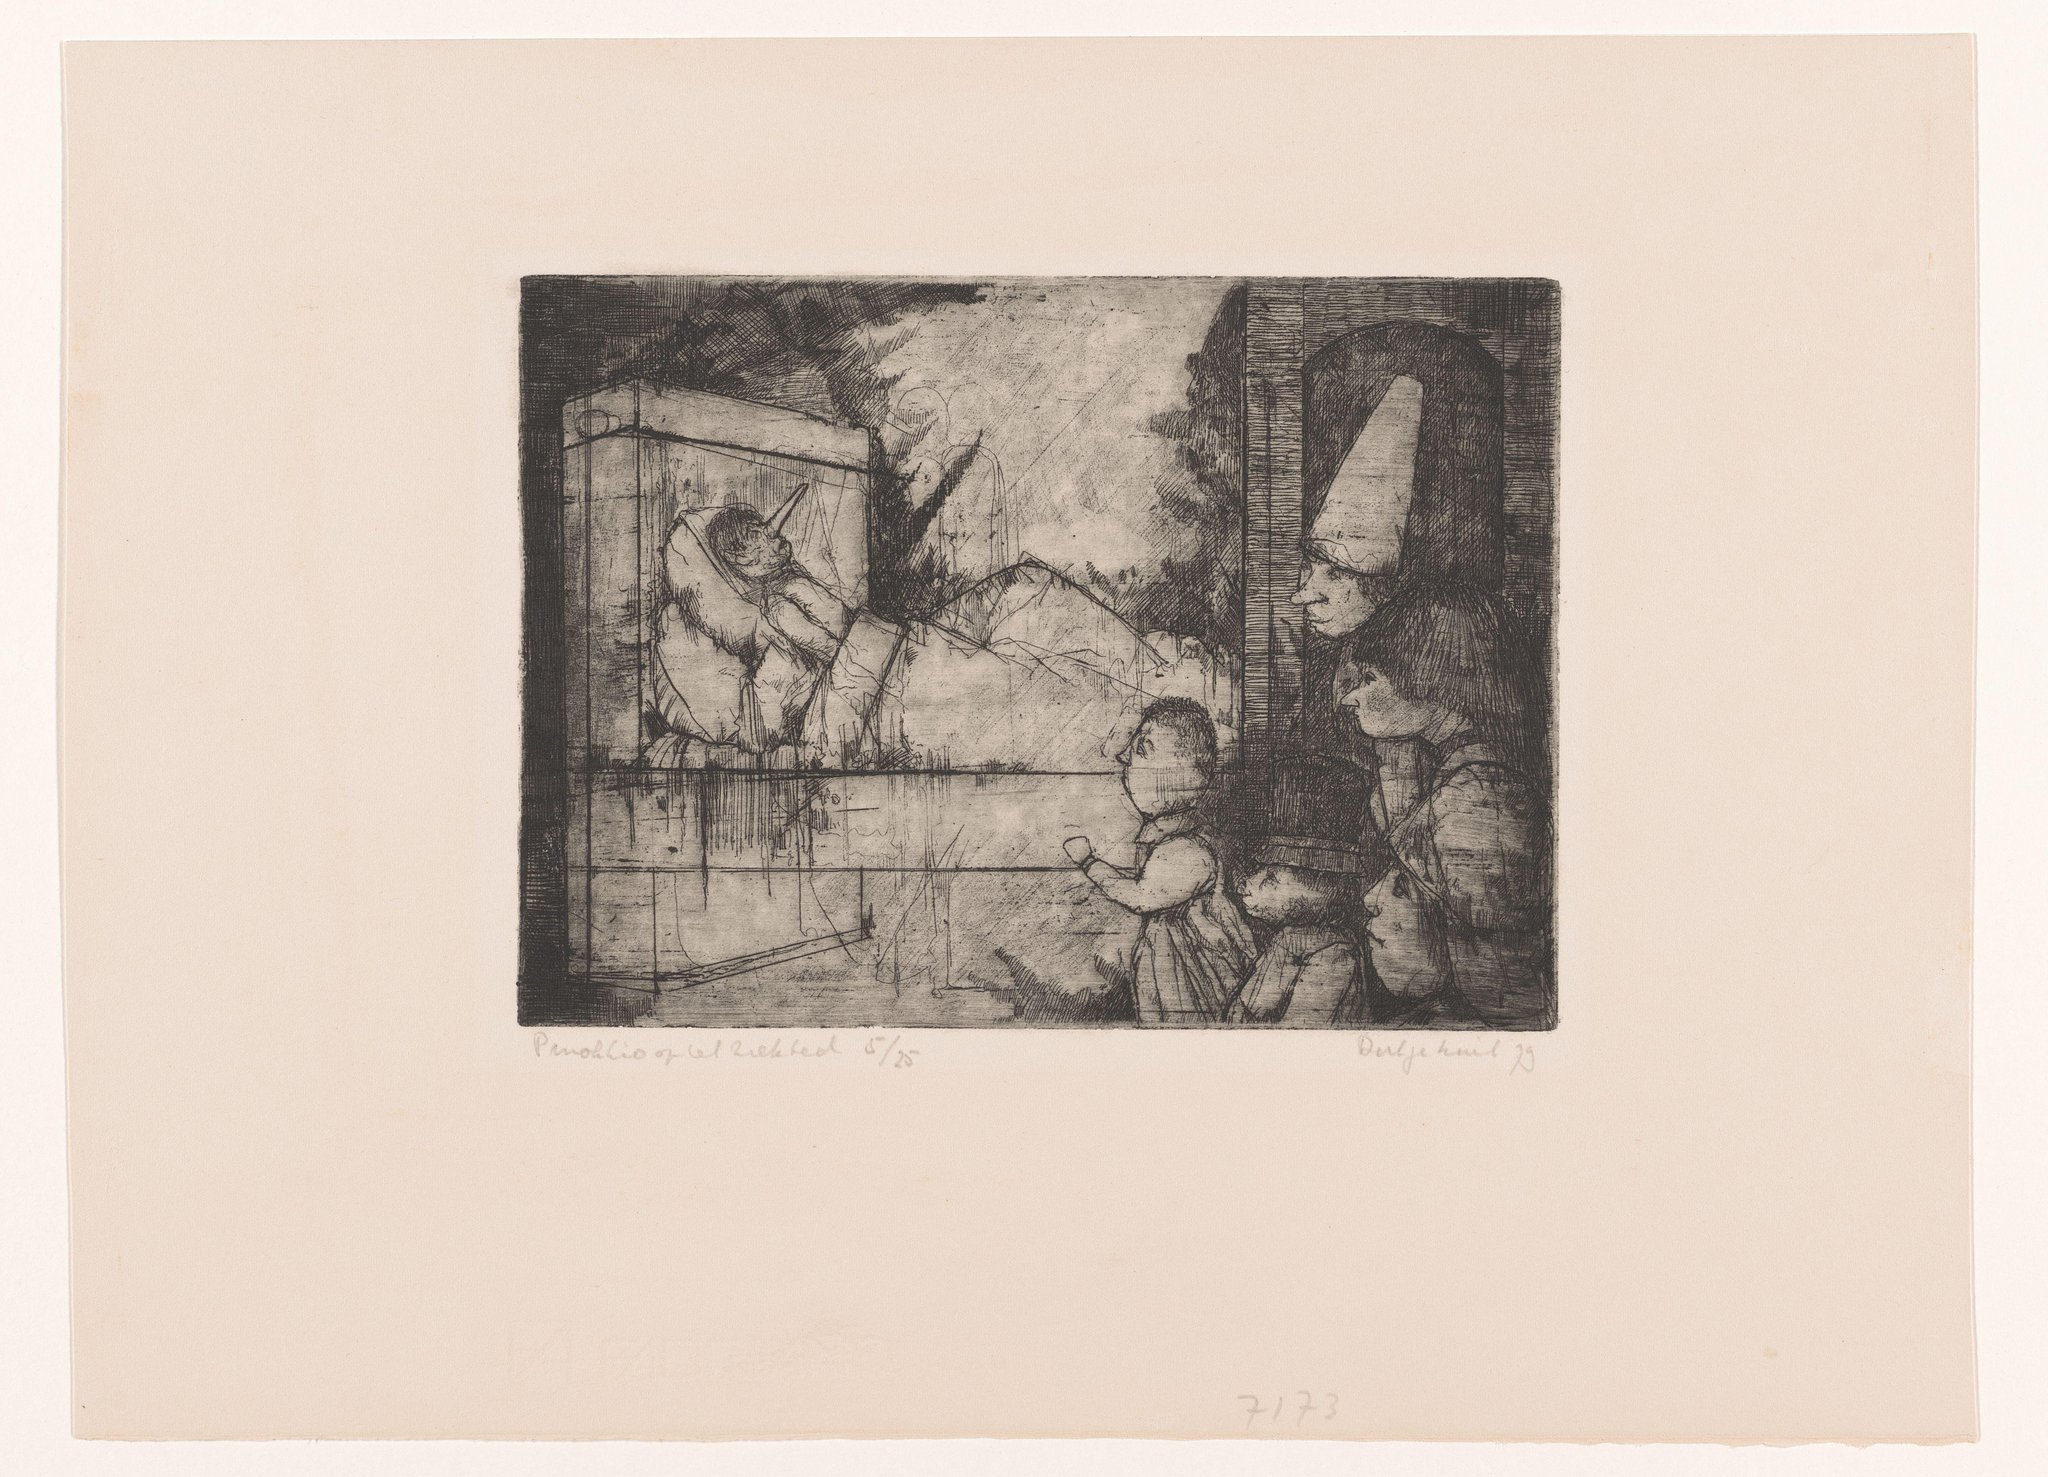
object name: print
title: Pinokkio op het ziekbed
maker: dirkje kuik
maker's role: print maker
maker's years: 1929-2008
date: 1979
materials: paper, ink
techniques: etching, intaglio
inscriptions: title: ‘Pinokkio op het ziekbed’, signature and date: ‘Dirkje Kuik 79’, edition: ‘5/25’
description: Jongen met lange neus liggend in bed, rechts vijf figuren die naar hem kijken.